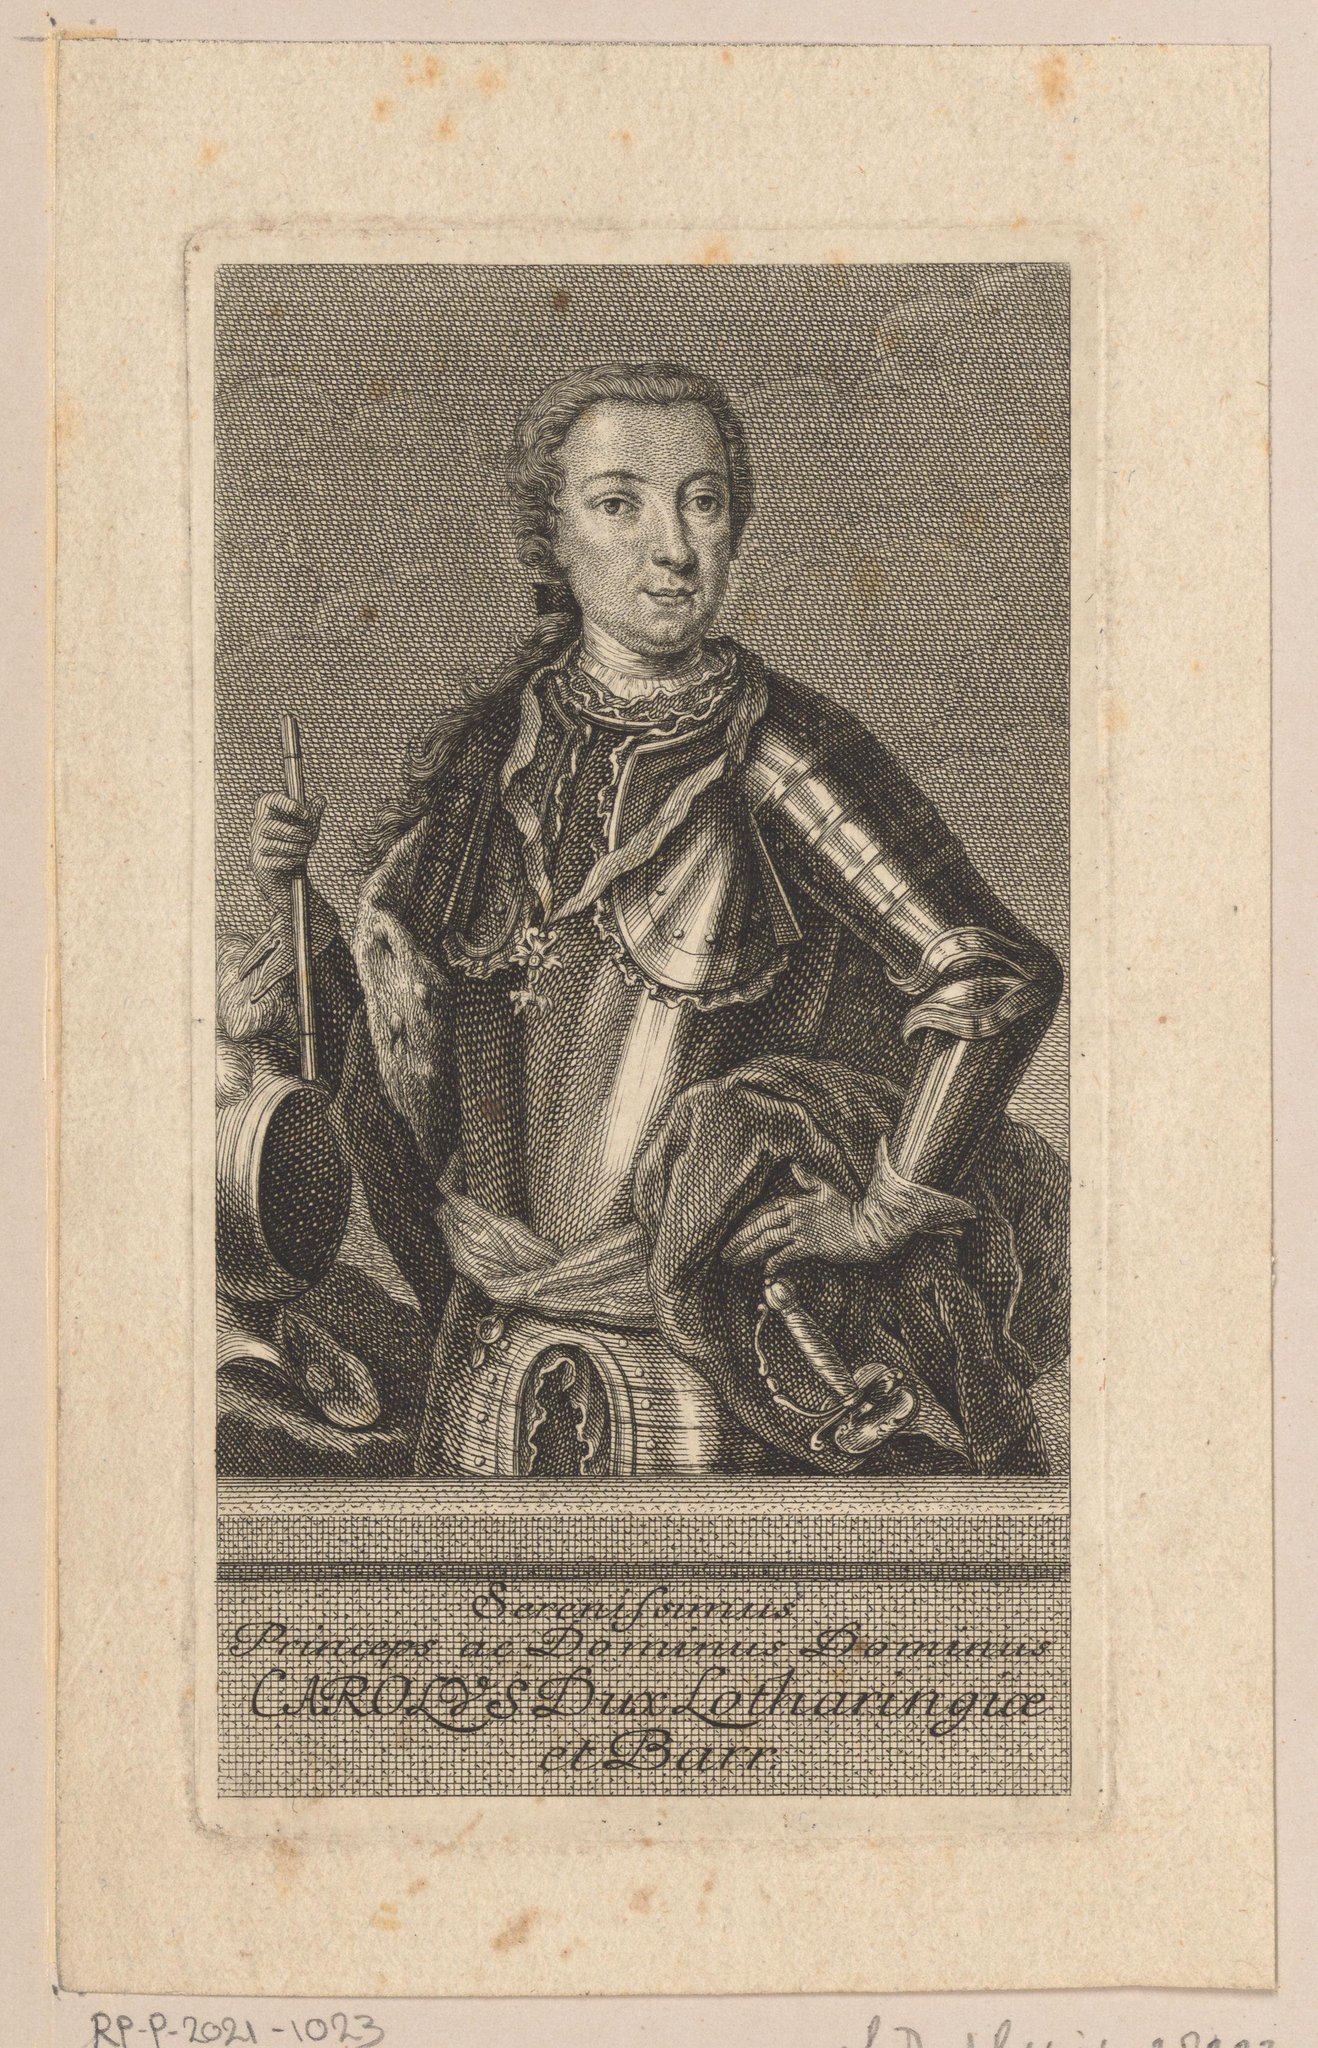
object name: print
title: Portret van Karel Alexander hertog van Lotharingen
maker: Anonymous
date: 1732-1799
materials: paper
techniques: engraving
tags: karel alexander hertog van lotharingen, historical persons, ruler, sovereign